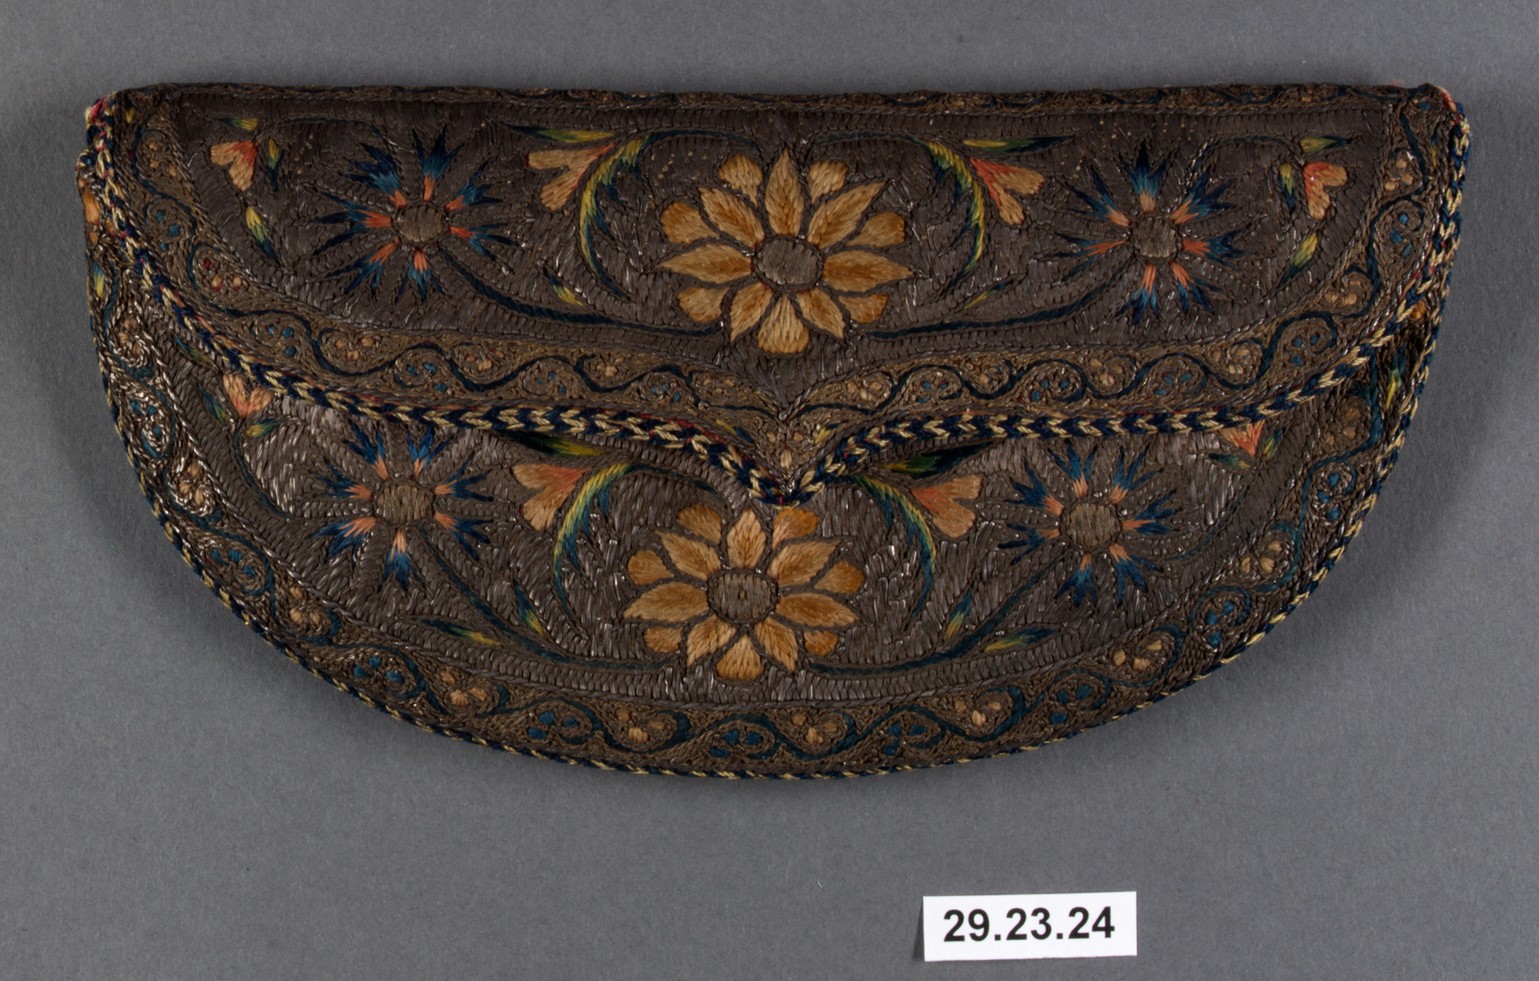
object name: bag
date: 1601-1700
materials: metal thread, silk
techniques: embroidery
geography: iran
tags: flowers